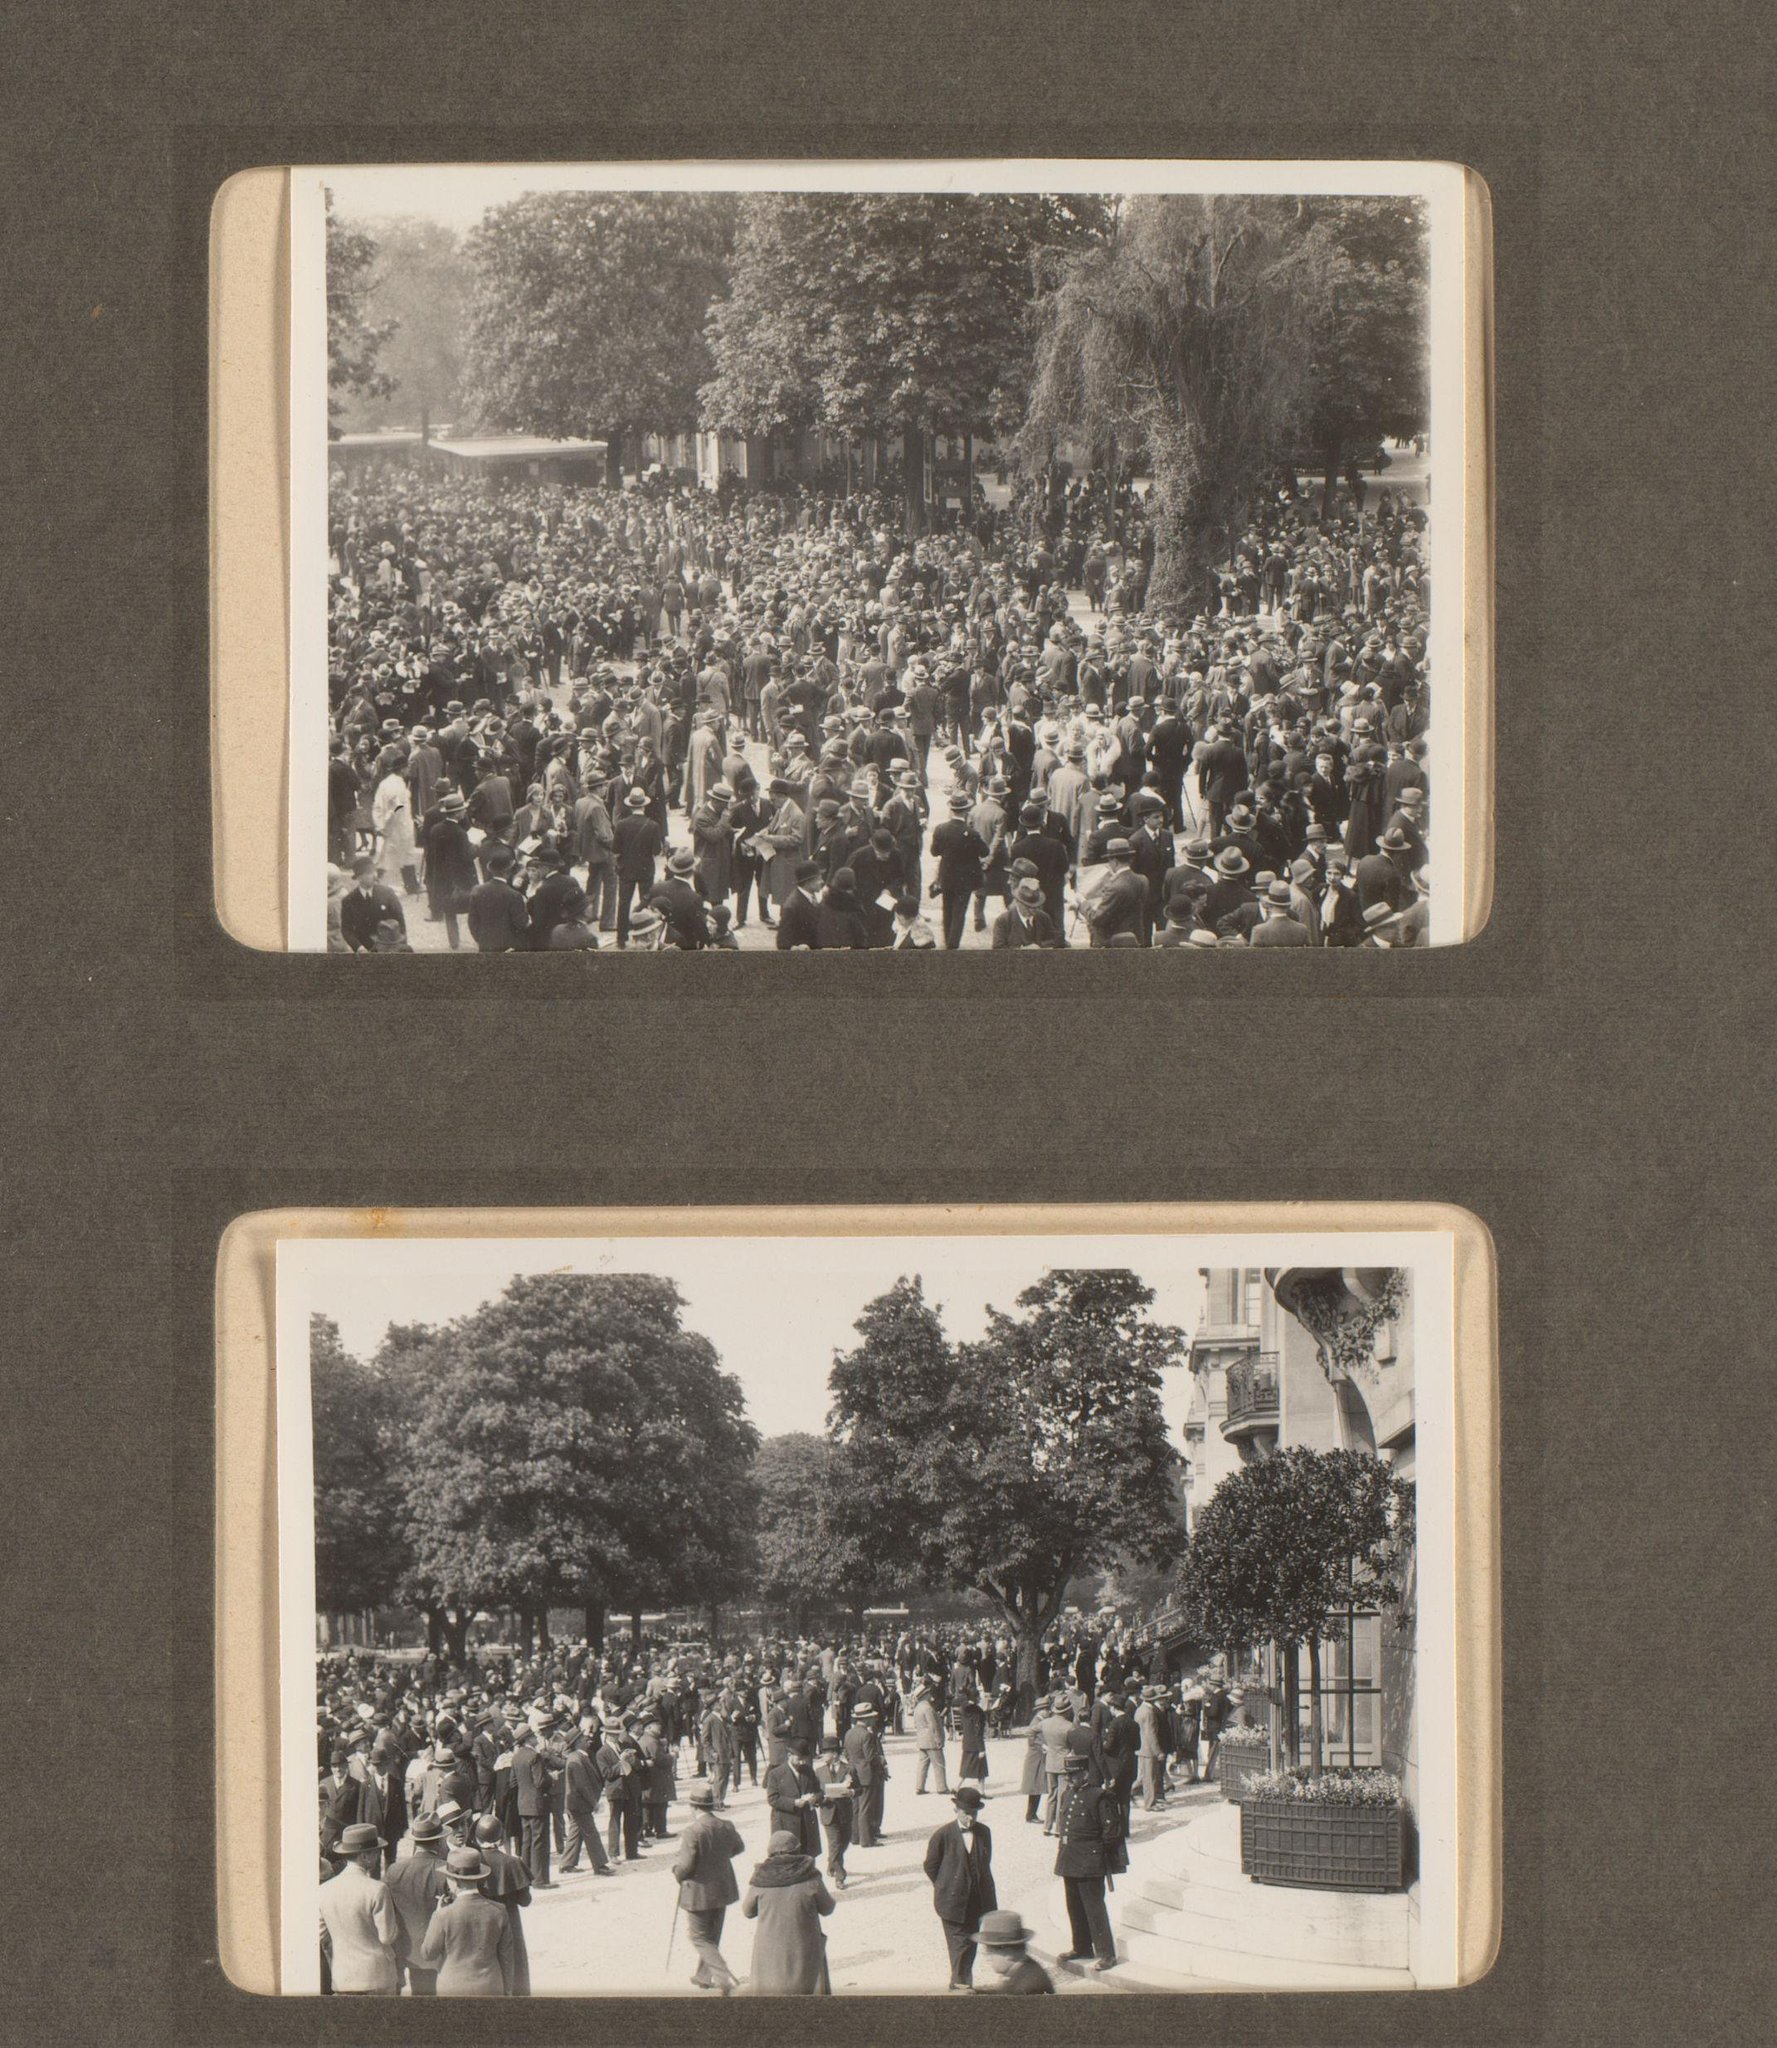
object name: photograph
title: Twee foto's van mensenmassa's op het terrein van het Hippodrome de Longchamp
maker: frank willem van den berg (1912-1998)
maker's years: 1912-1998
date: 1904-1930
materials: paper, cardboard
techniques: gelatin silver print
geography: paris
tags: race-track (+ out of doors (sports, games, etc.)), historical persons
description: Deze foto's maken deel uit van een album.